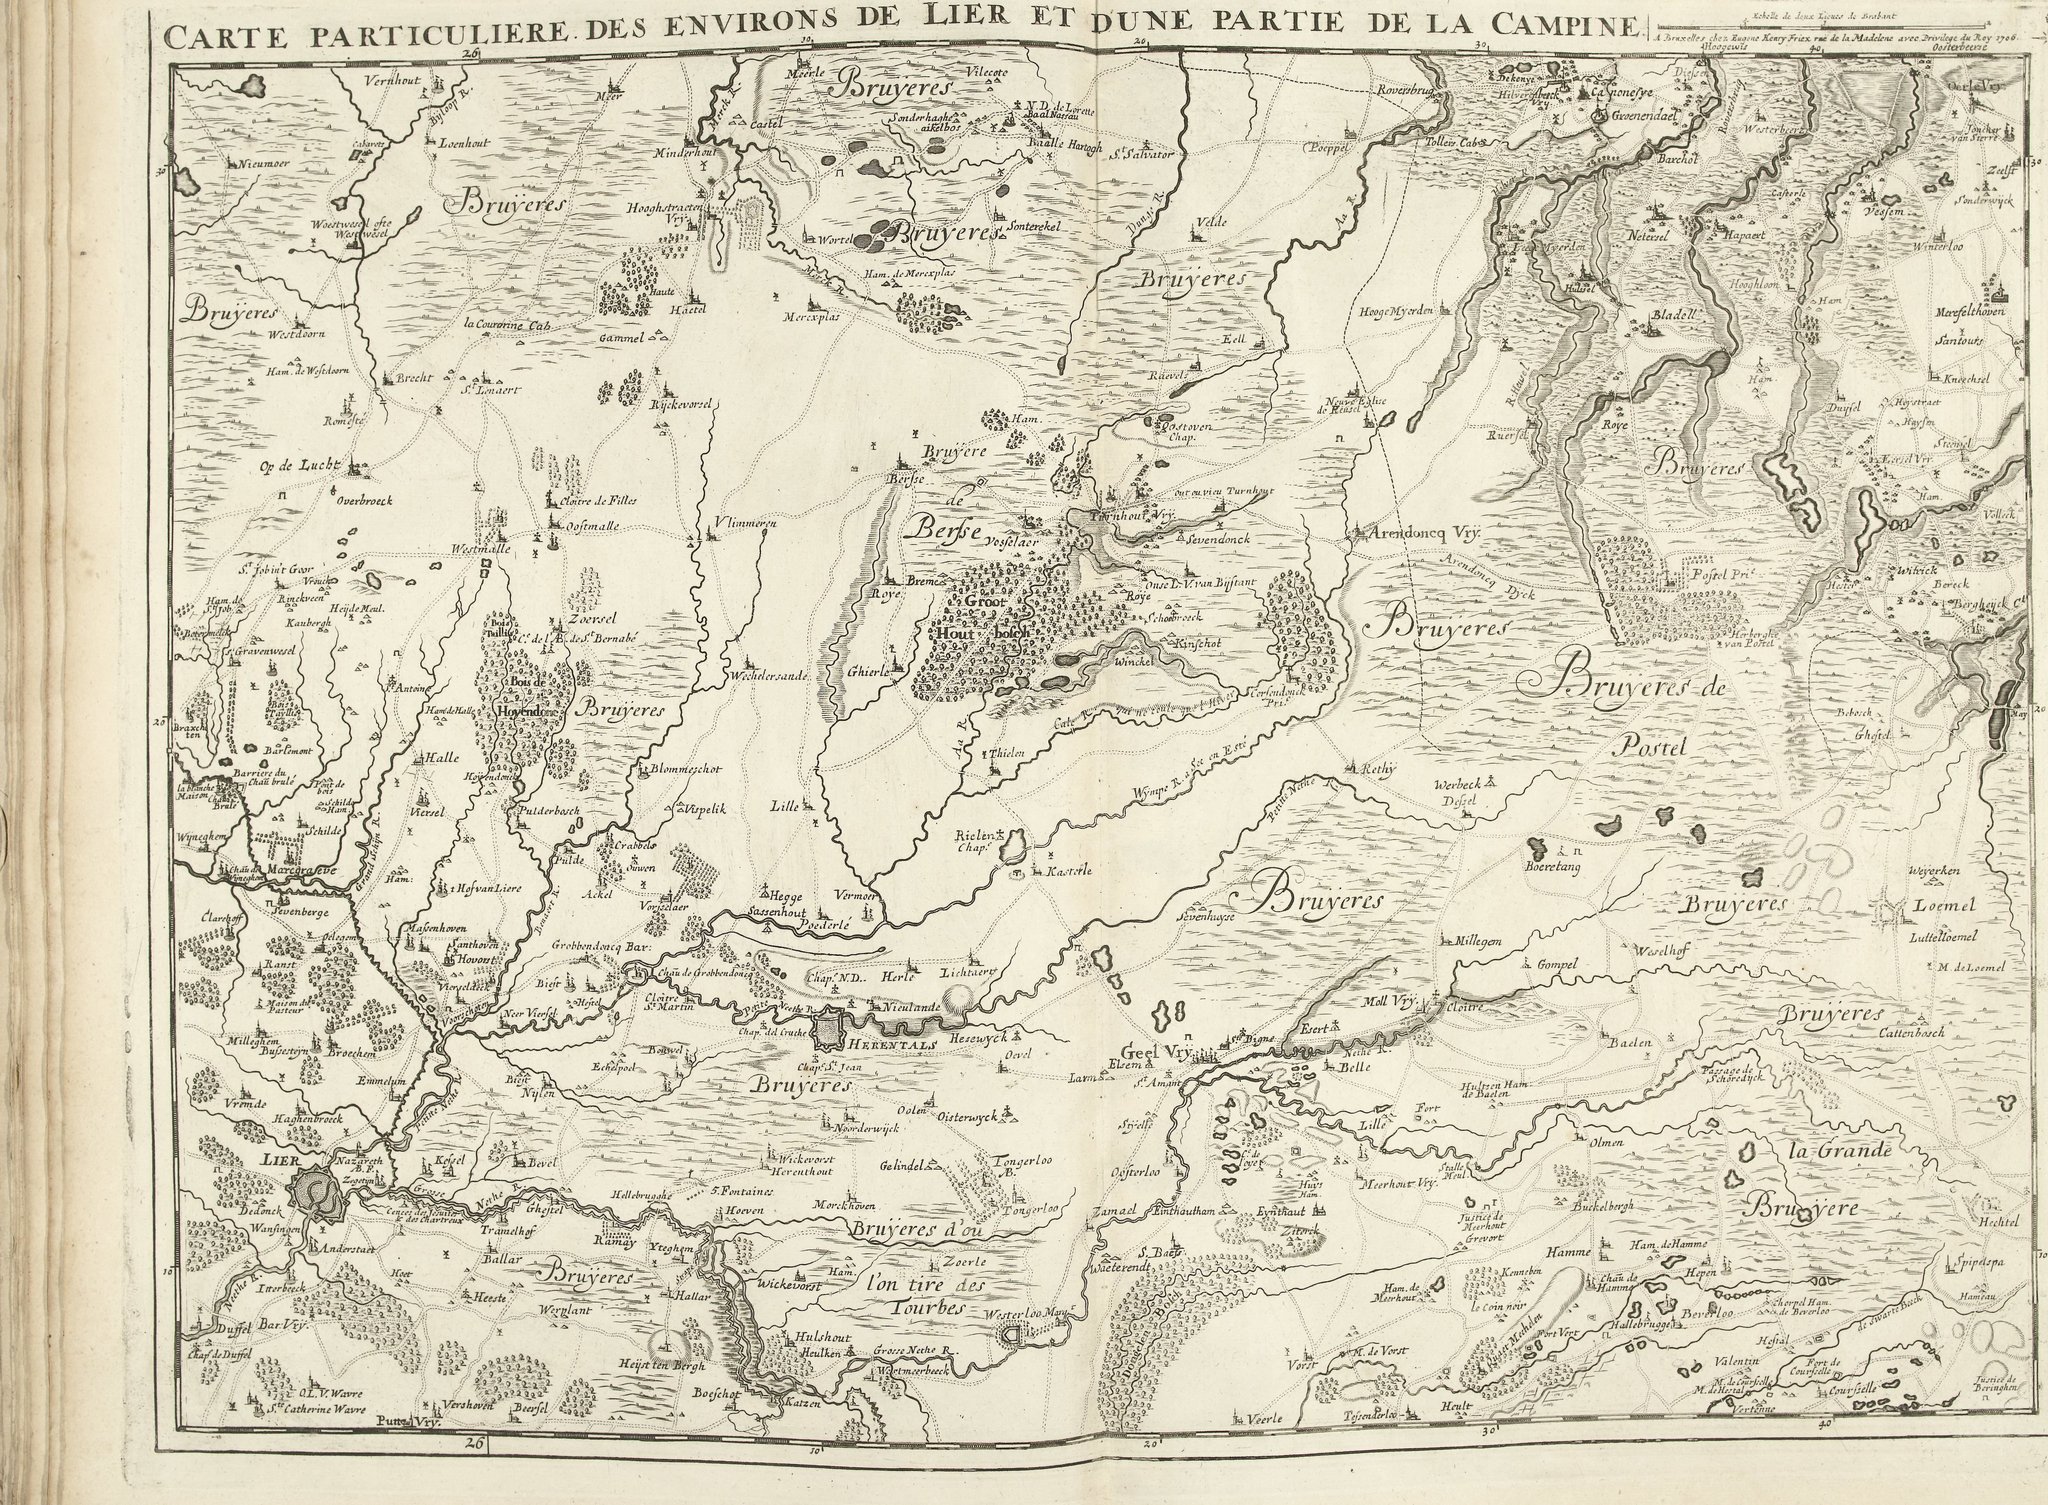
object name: map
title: Carte particuliere des environs de Lier et d'une partie de la Campine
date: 1706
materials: paper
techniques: engraving, etching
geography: brussels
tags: maps of separate countries or regions, antwerp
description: Kaart van de provincie Antwerpen met de stad Lier en een deel van de Kempen, 1706. Onderdeel van een gebundelde verzameling van plannen van veldslagen en steden vermaard in de Spaanse Successieoorlog. Deze plaat behoort tot de eerste 24 platen die samen een zeer grote kaart van de Zuidelijke Nederlanden vormen.